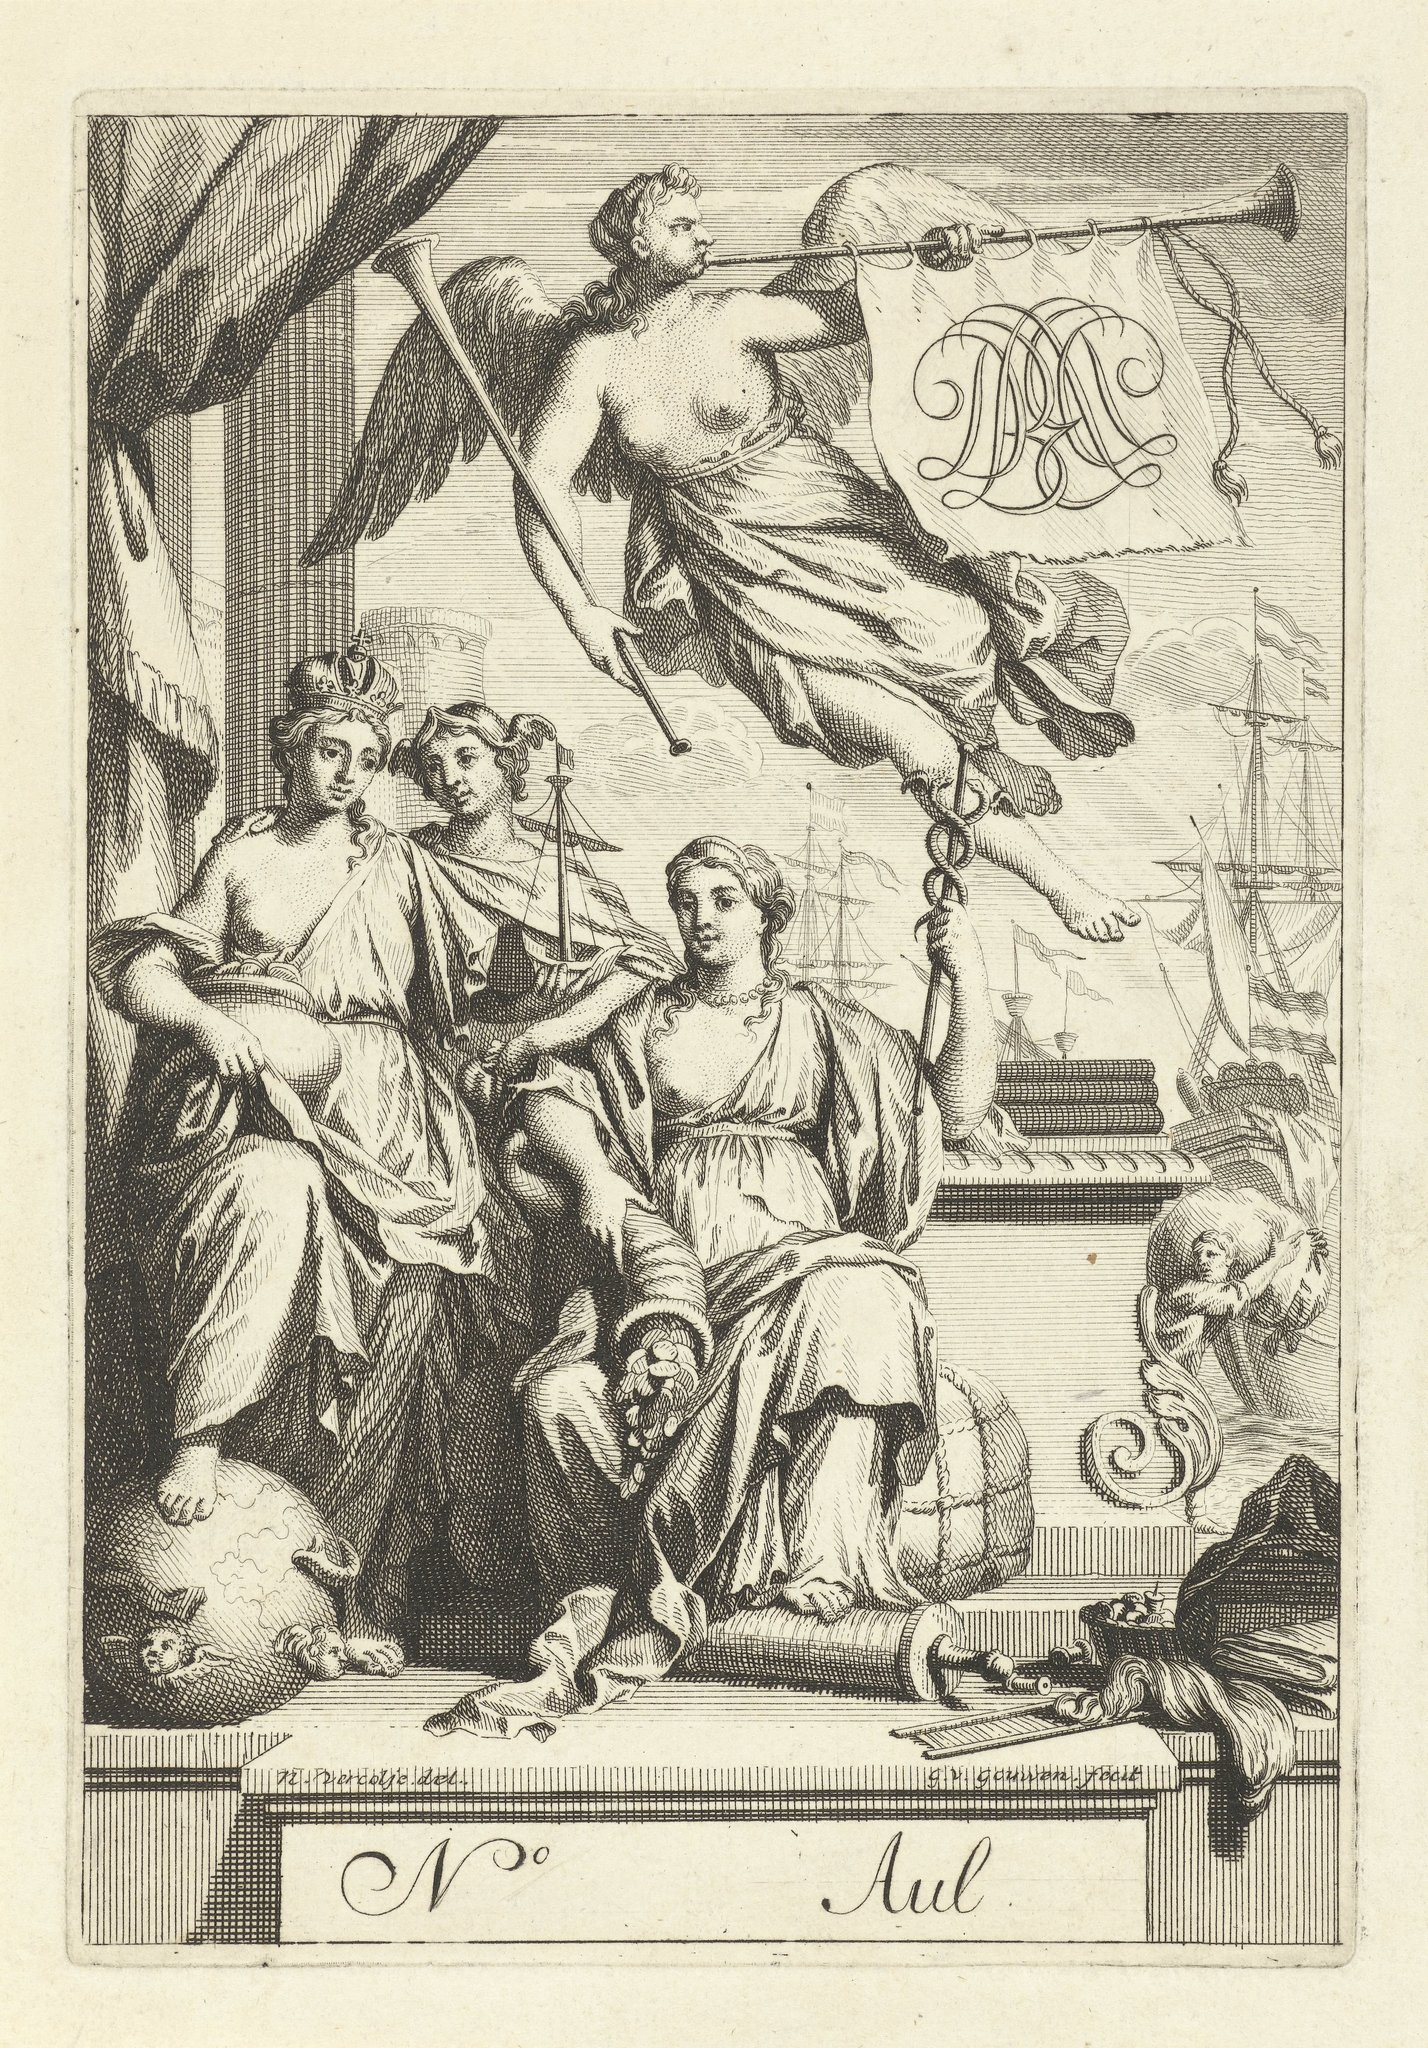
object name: print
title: Faam vliegt over de personificaties van handel, overvloed en zeevaart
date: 1683-1740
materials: paper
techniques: engraving, etching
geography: amsterdam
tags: 'cornucopia', horn of plenty, (story of) mercury (hermes), abundance; 'abondanza', 'abondanza maritima' (ripa), fame; 'fama', 'fama buona', 'fama chiara' (ripa), allegory of trade; 'commertio della vita humana' (ripa), 'navigatione' (ripa)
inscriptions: collector's mark: Lugt 240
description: Faam vliegt over een haven en blaast op de loftrompet. Aan de havenkade zit de personificatie Overvloed met de cornucopia in de hand. Naast Overvloed staan Mercurius, god van de handel, en de personificatie van Zeevaart, met als attributen een wereldbol en een zeilschip.